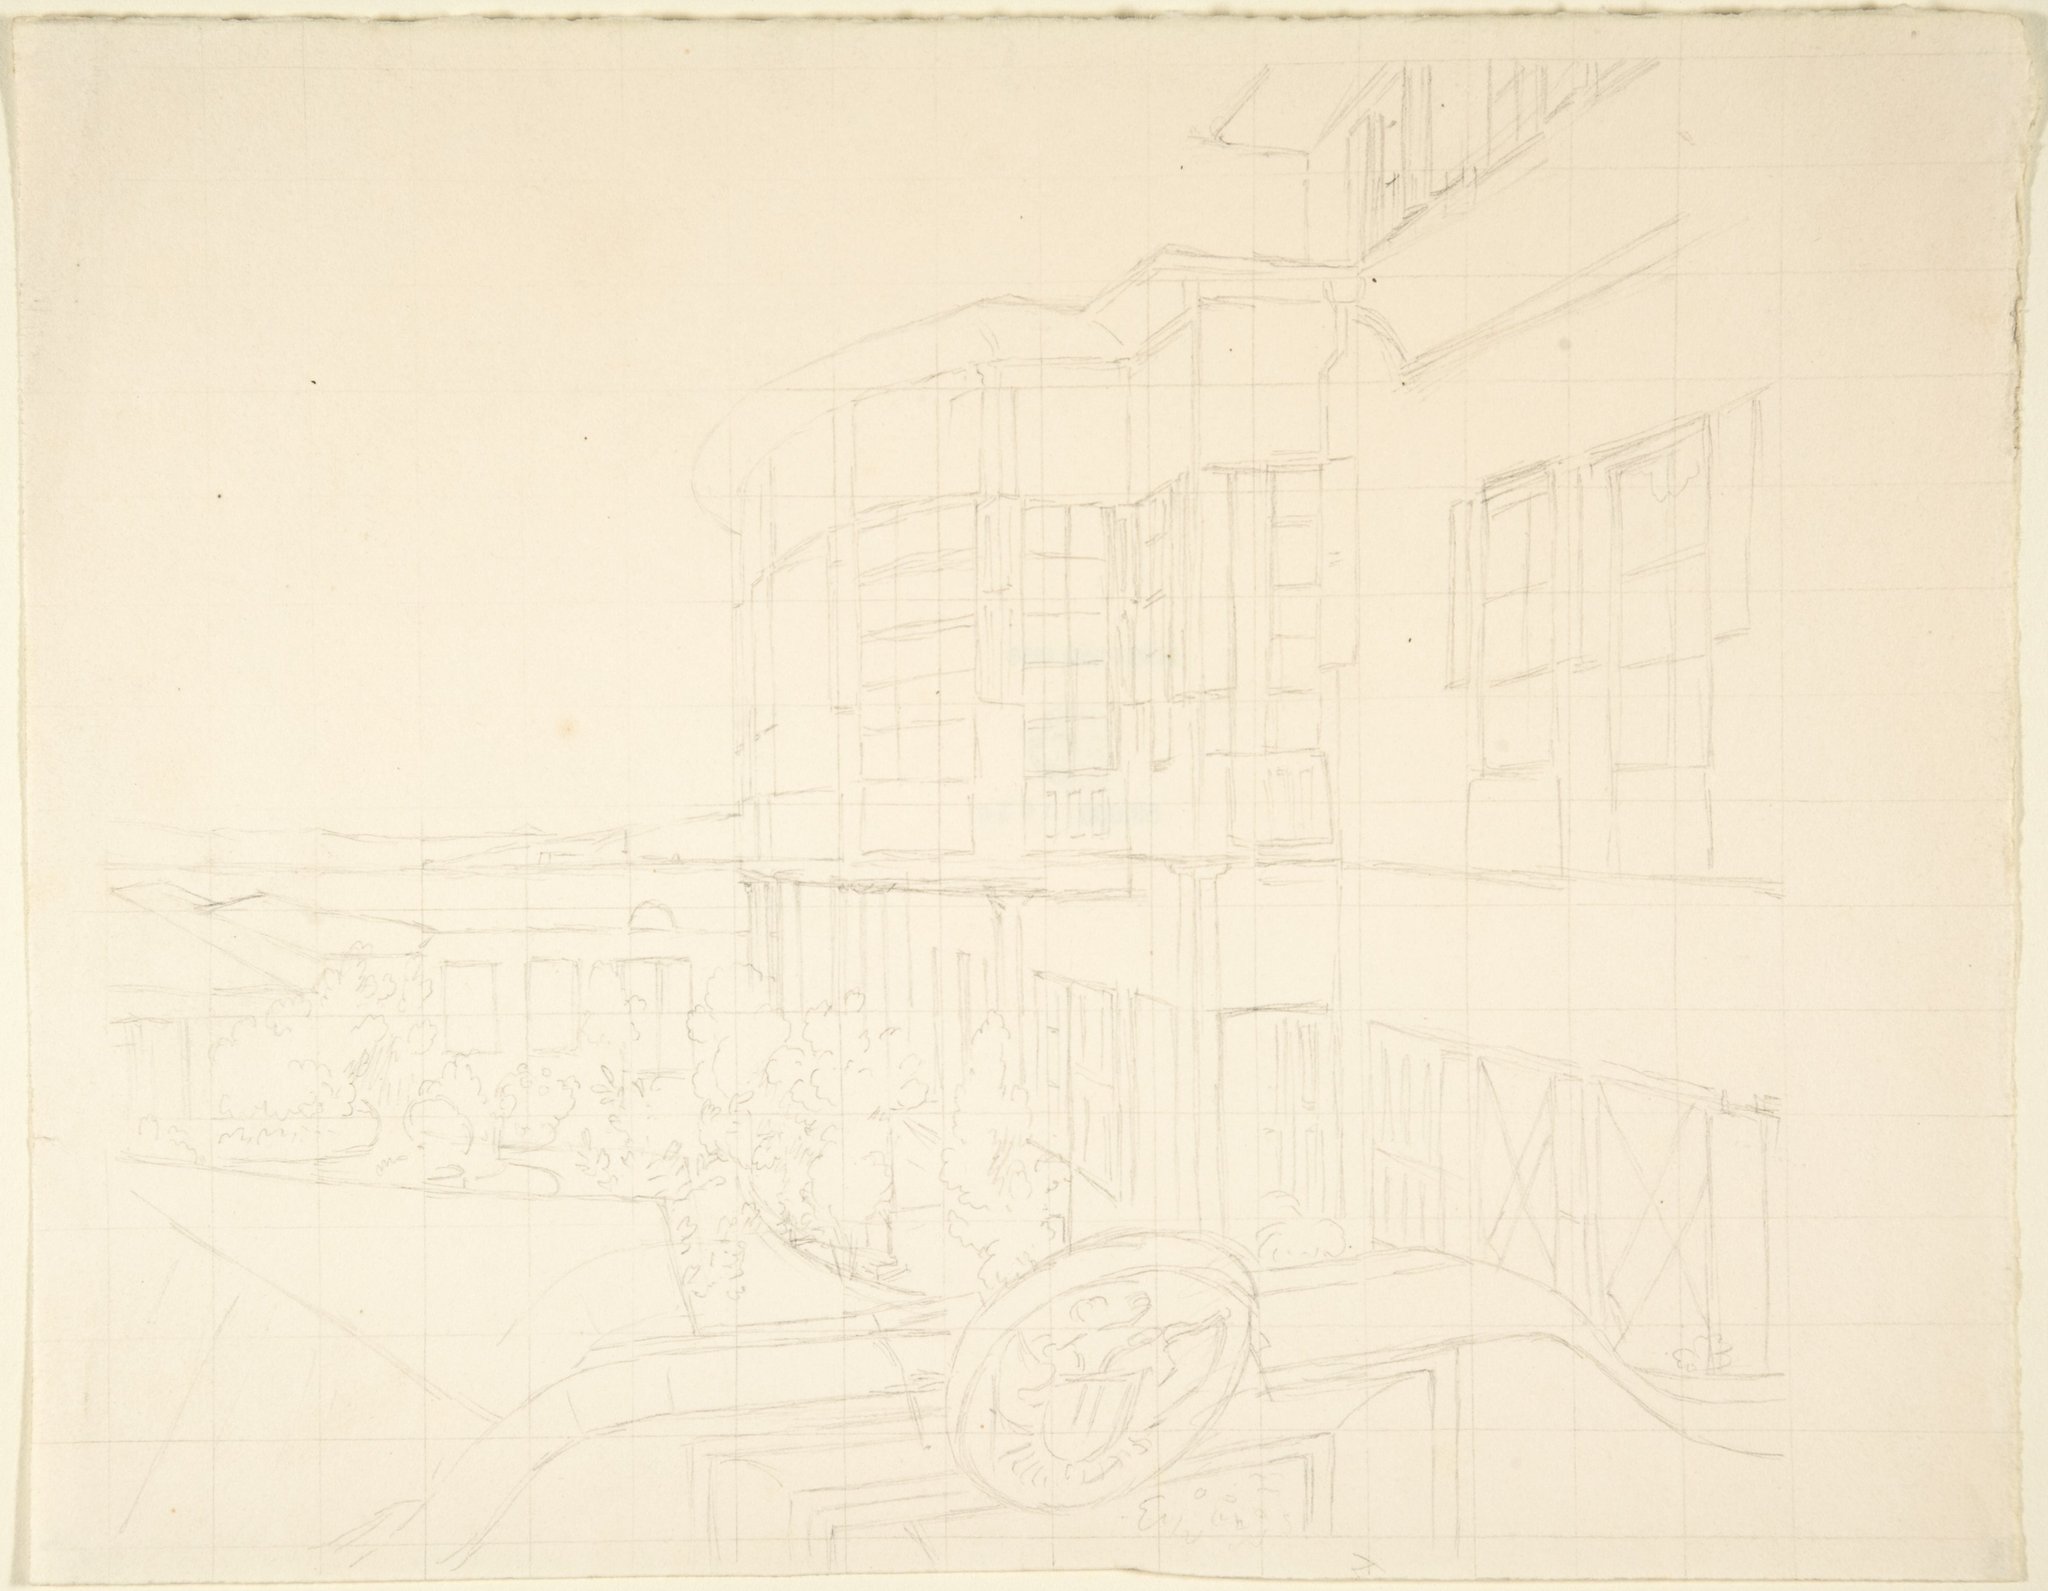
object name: drawing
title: Sketch of Building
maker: franz von hauslab the younger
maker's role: artist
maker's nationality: austrian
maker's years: 1798-1883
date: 1801-1900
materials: graphite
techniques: drawing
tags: buildings